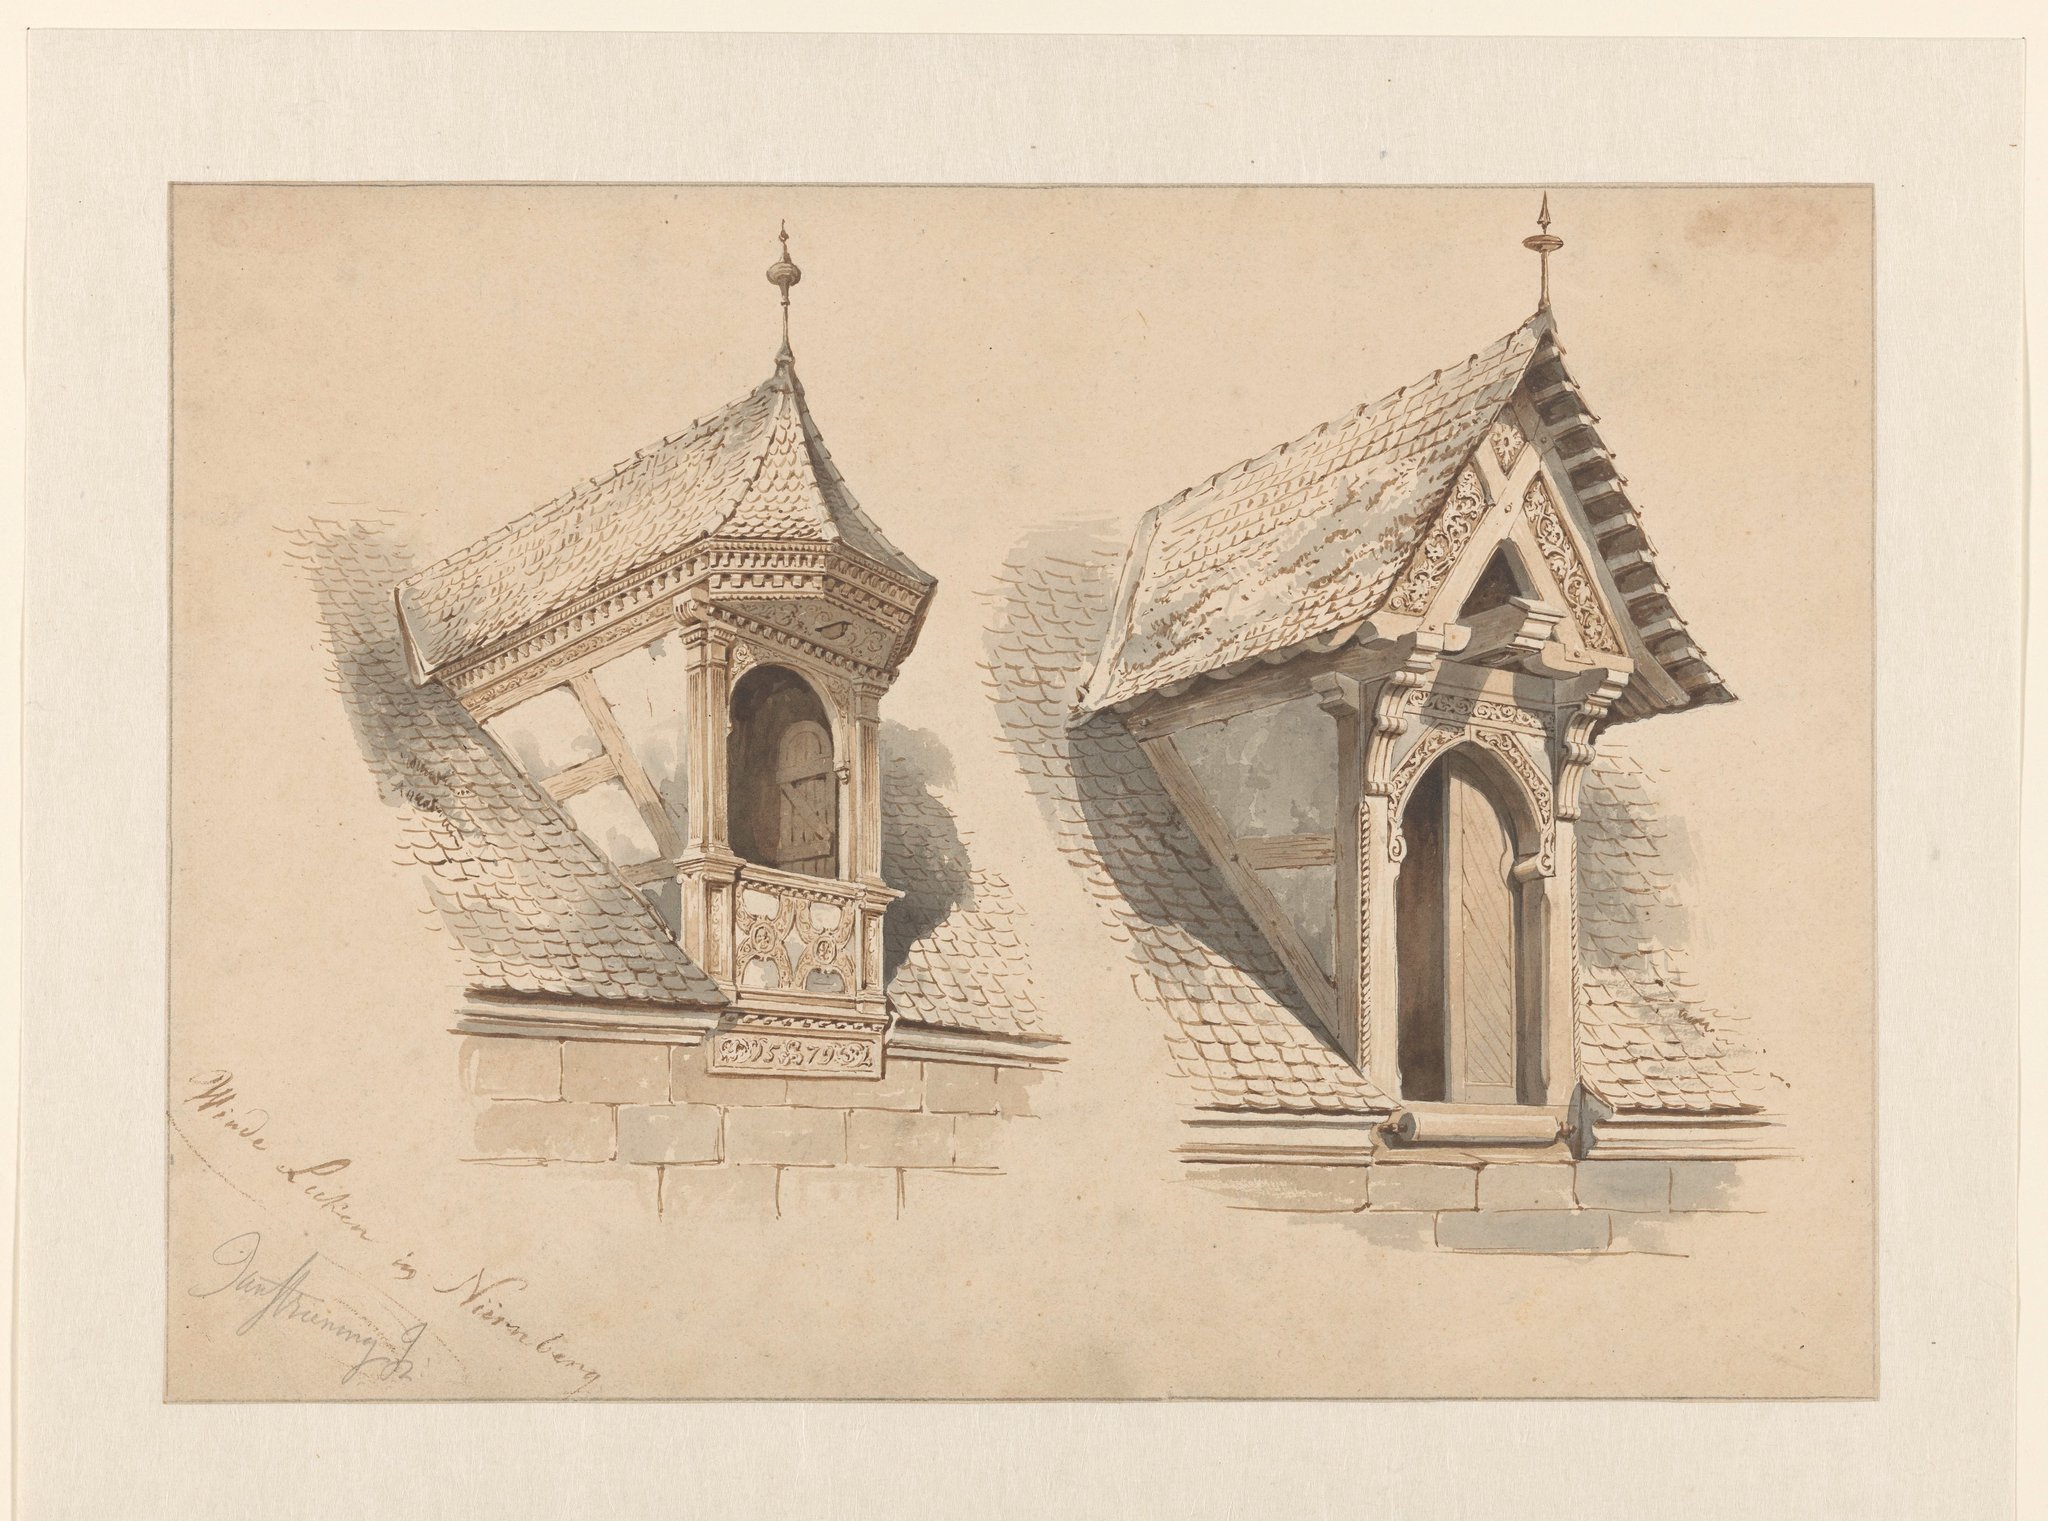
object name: drawing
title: Twee dakkapellen te Nürnberg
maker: jan striening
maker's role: draughtsman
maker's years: 1827-1903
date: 1837-1903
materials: ink, paper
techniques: brush, pen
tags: roof (of house or building), window